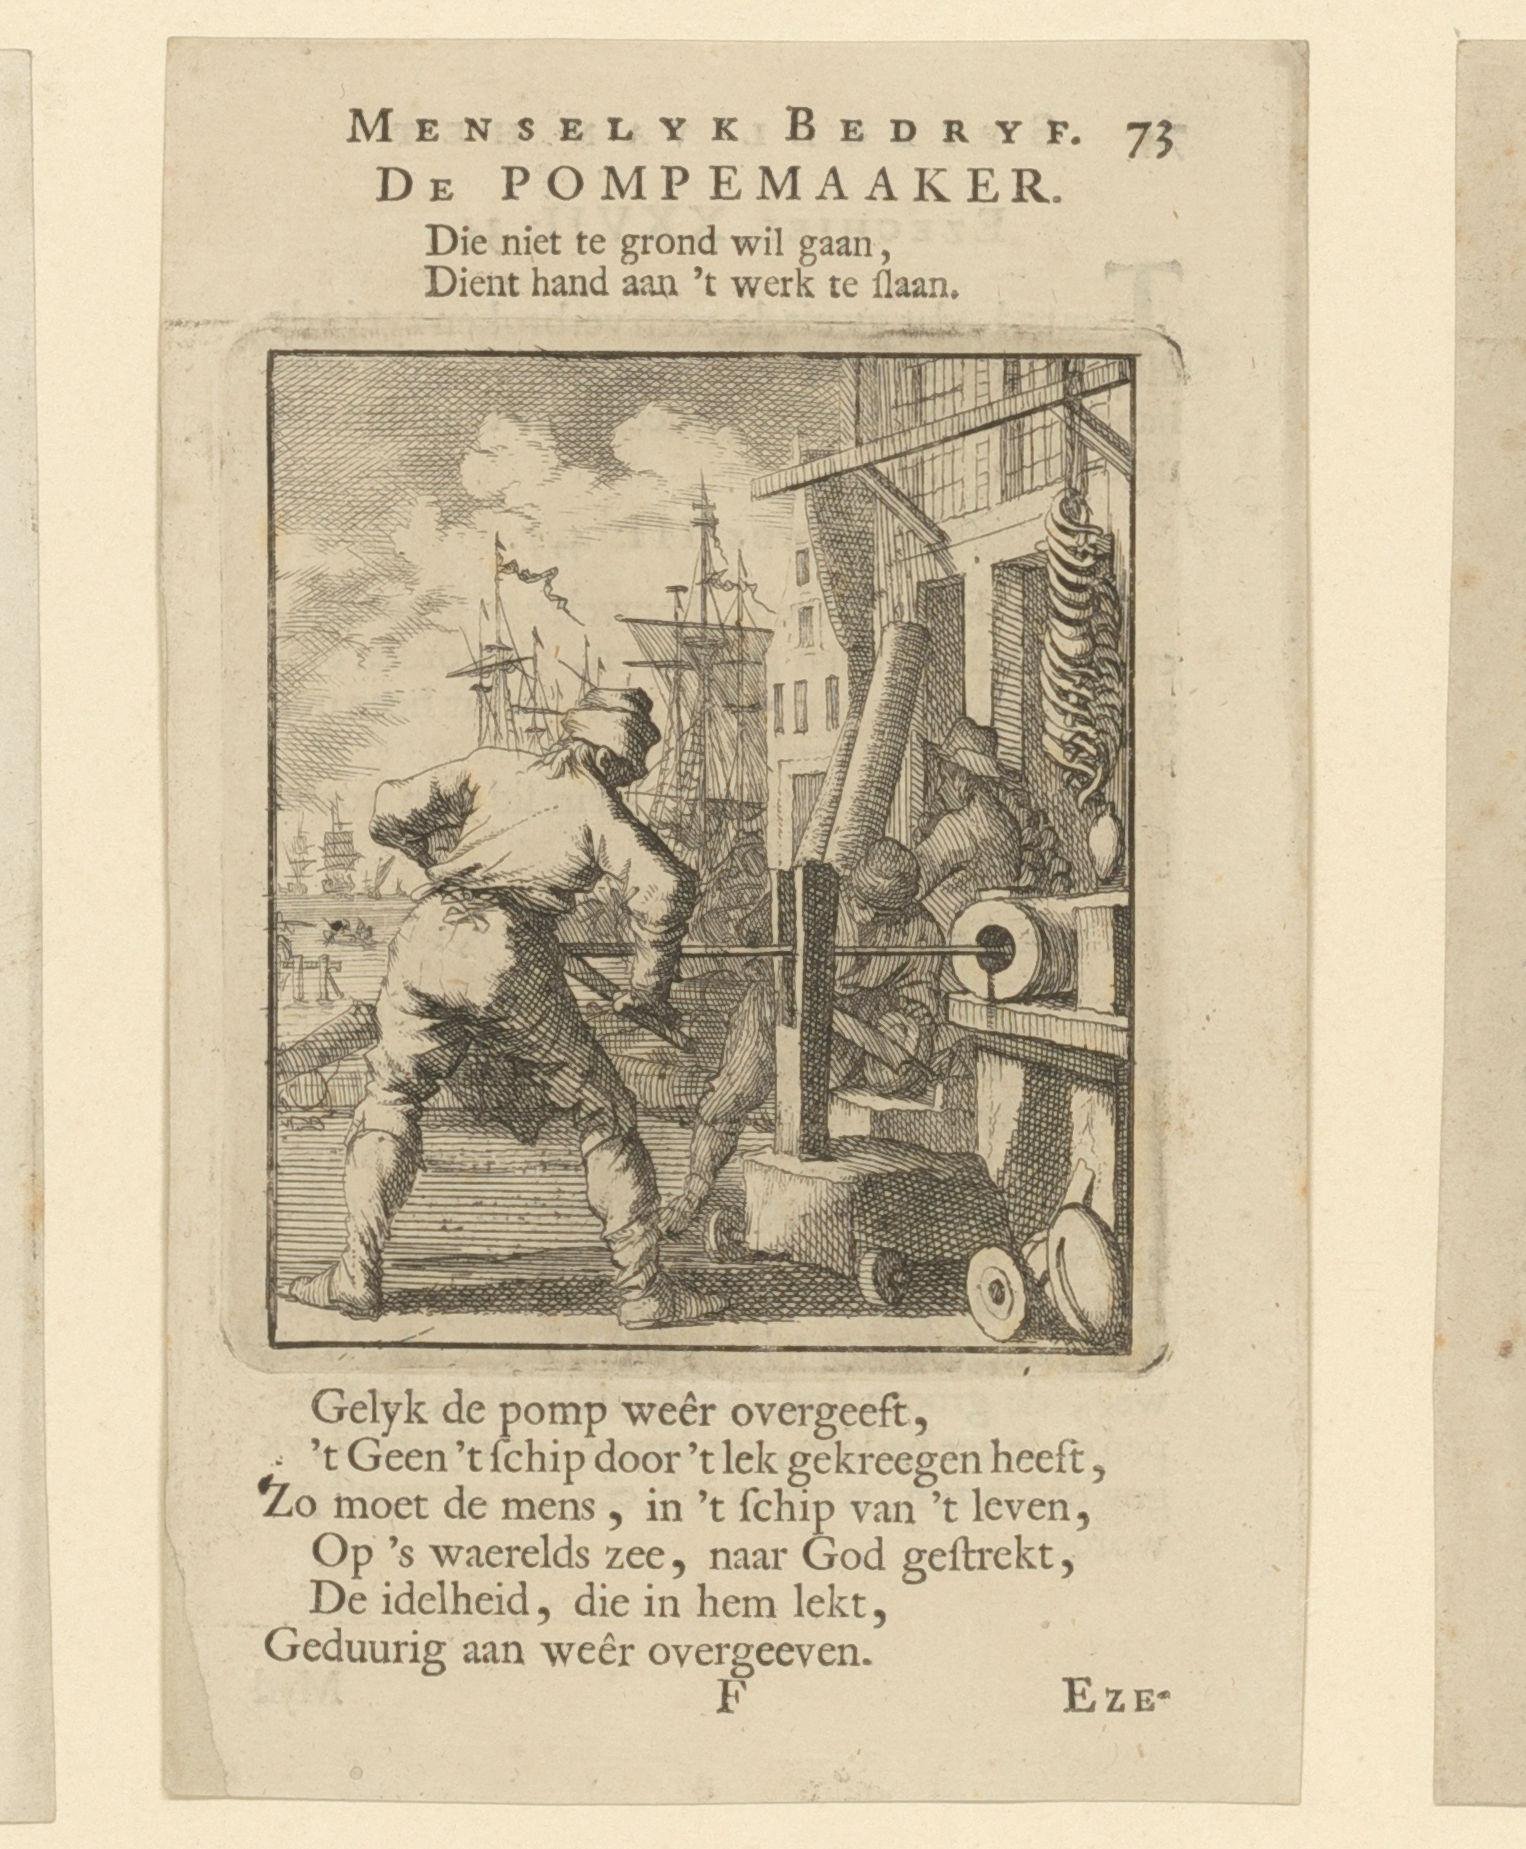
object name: book illustration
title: De Pompemaaker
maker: cornelis van der sys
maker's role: publisher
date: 1718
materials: paper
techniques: etching, letterpress printing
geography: amsterdam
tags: handicrafts, craftsman at work, pump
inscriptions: collector's mark: Lugt 1641, stamp, stamp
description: Prent oorspronkelijk verschenen in de 100-delige serie beroepsprenten van Jan en Caspar Luyken, getiteld: Het menselyk bedryf. S.l.s.n., 1694 (eerste druk). Huidige staat uit: Luyken, Jan en Caspar. Spiegel van het menselyk bedryf (...). Amsterdam: Cornelis van der Sys, 1718, p. 73. Prent waarschijnlijk ook gebruikt in eerdere (1704) en latere (1730, 1749, 1767) publicaties.